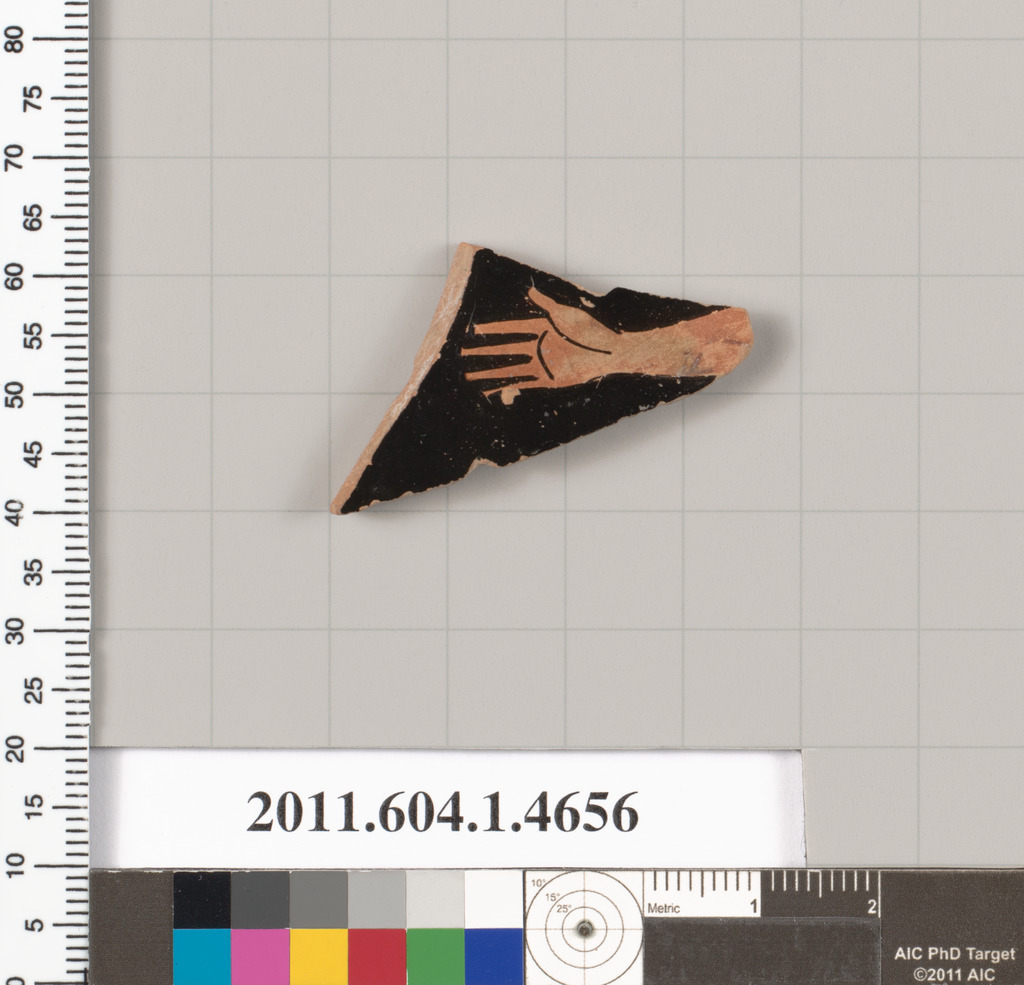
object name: kylix fragment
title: Terracotta fragment of a kylix (drinking cup)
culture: greek, attic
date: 520-500 BCE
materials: terracotta